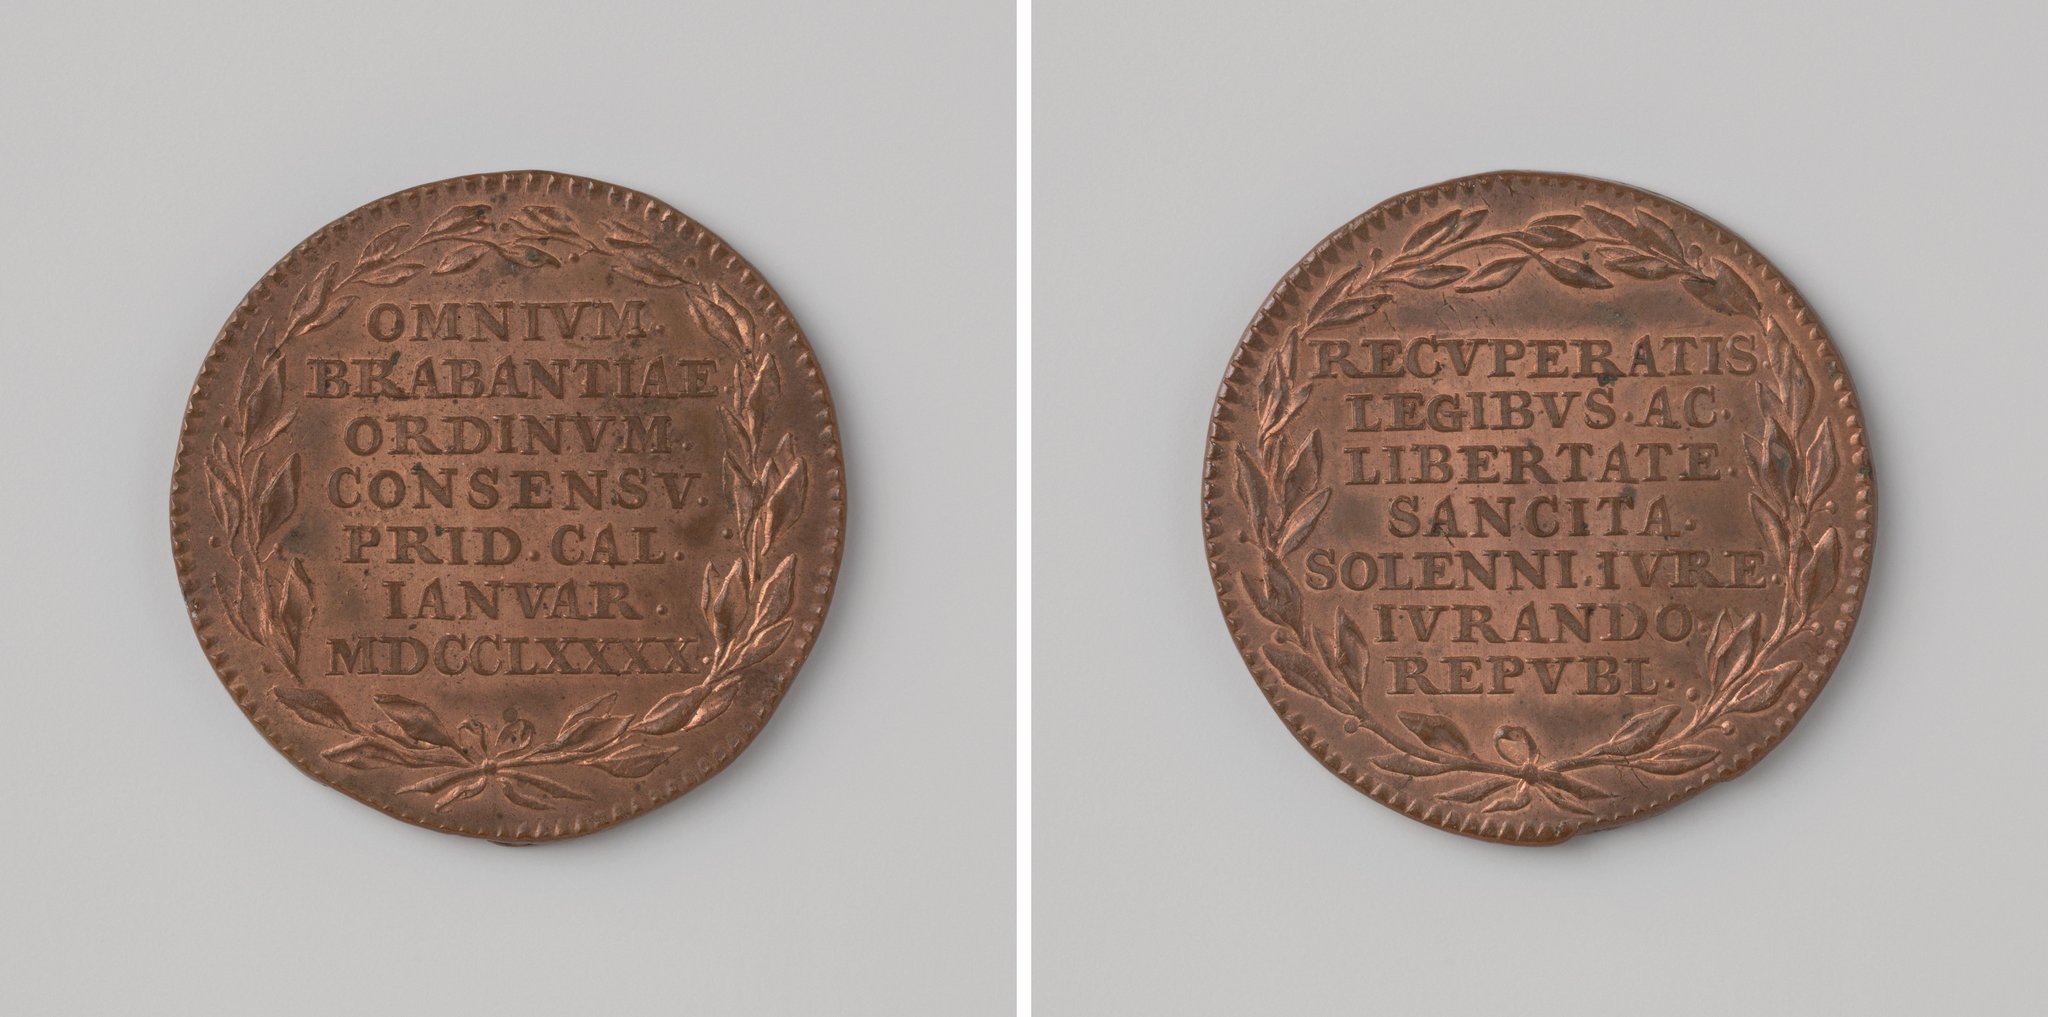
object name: history medal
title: Brabant vrij verklaard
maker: Anonymous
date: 1789-1790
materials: copper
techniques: striking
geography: brabant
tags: brabant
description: Koperen penning. Voorzijde: opschrift binnen lauwerkrans. Keerzijde: opschrift binnen lauwerkrans